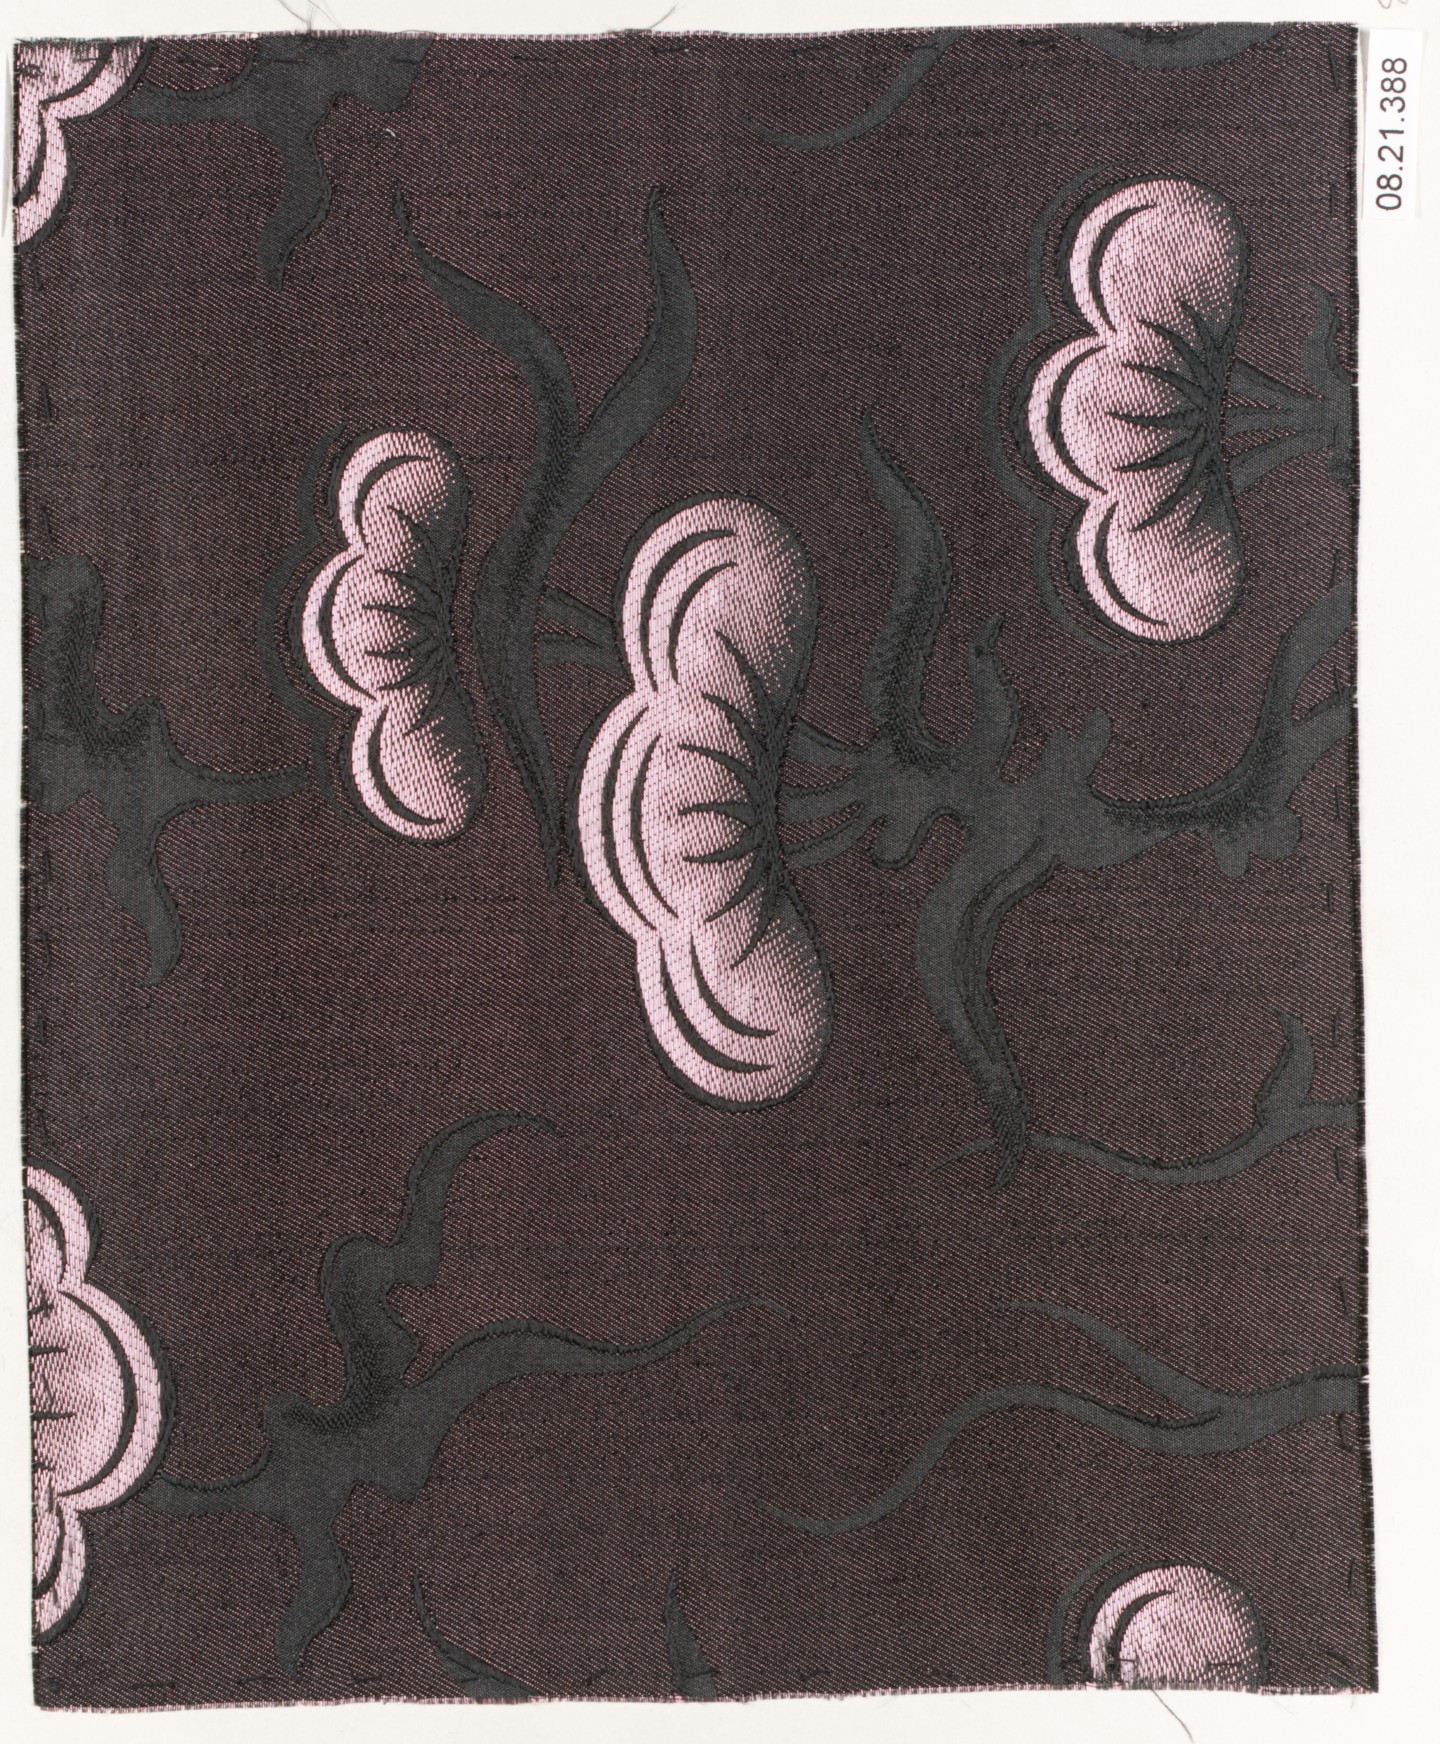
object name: textile sample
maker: Anonymous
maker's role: designer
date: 1900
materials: silk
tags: flowers